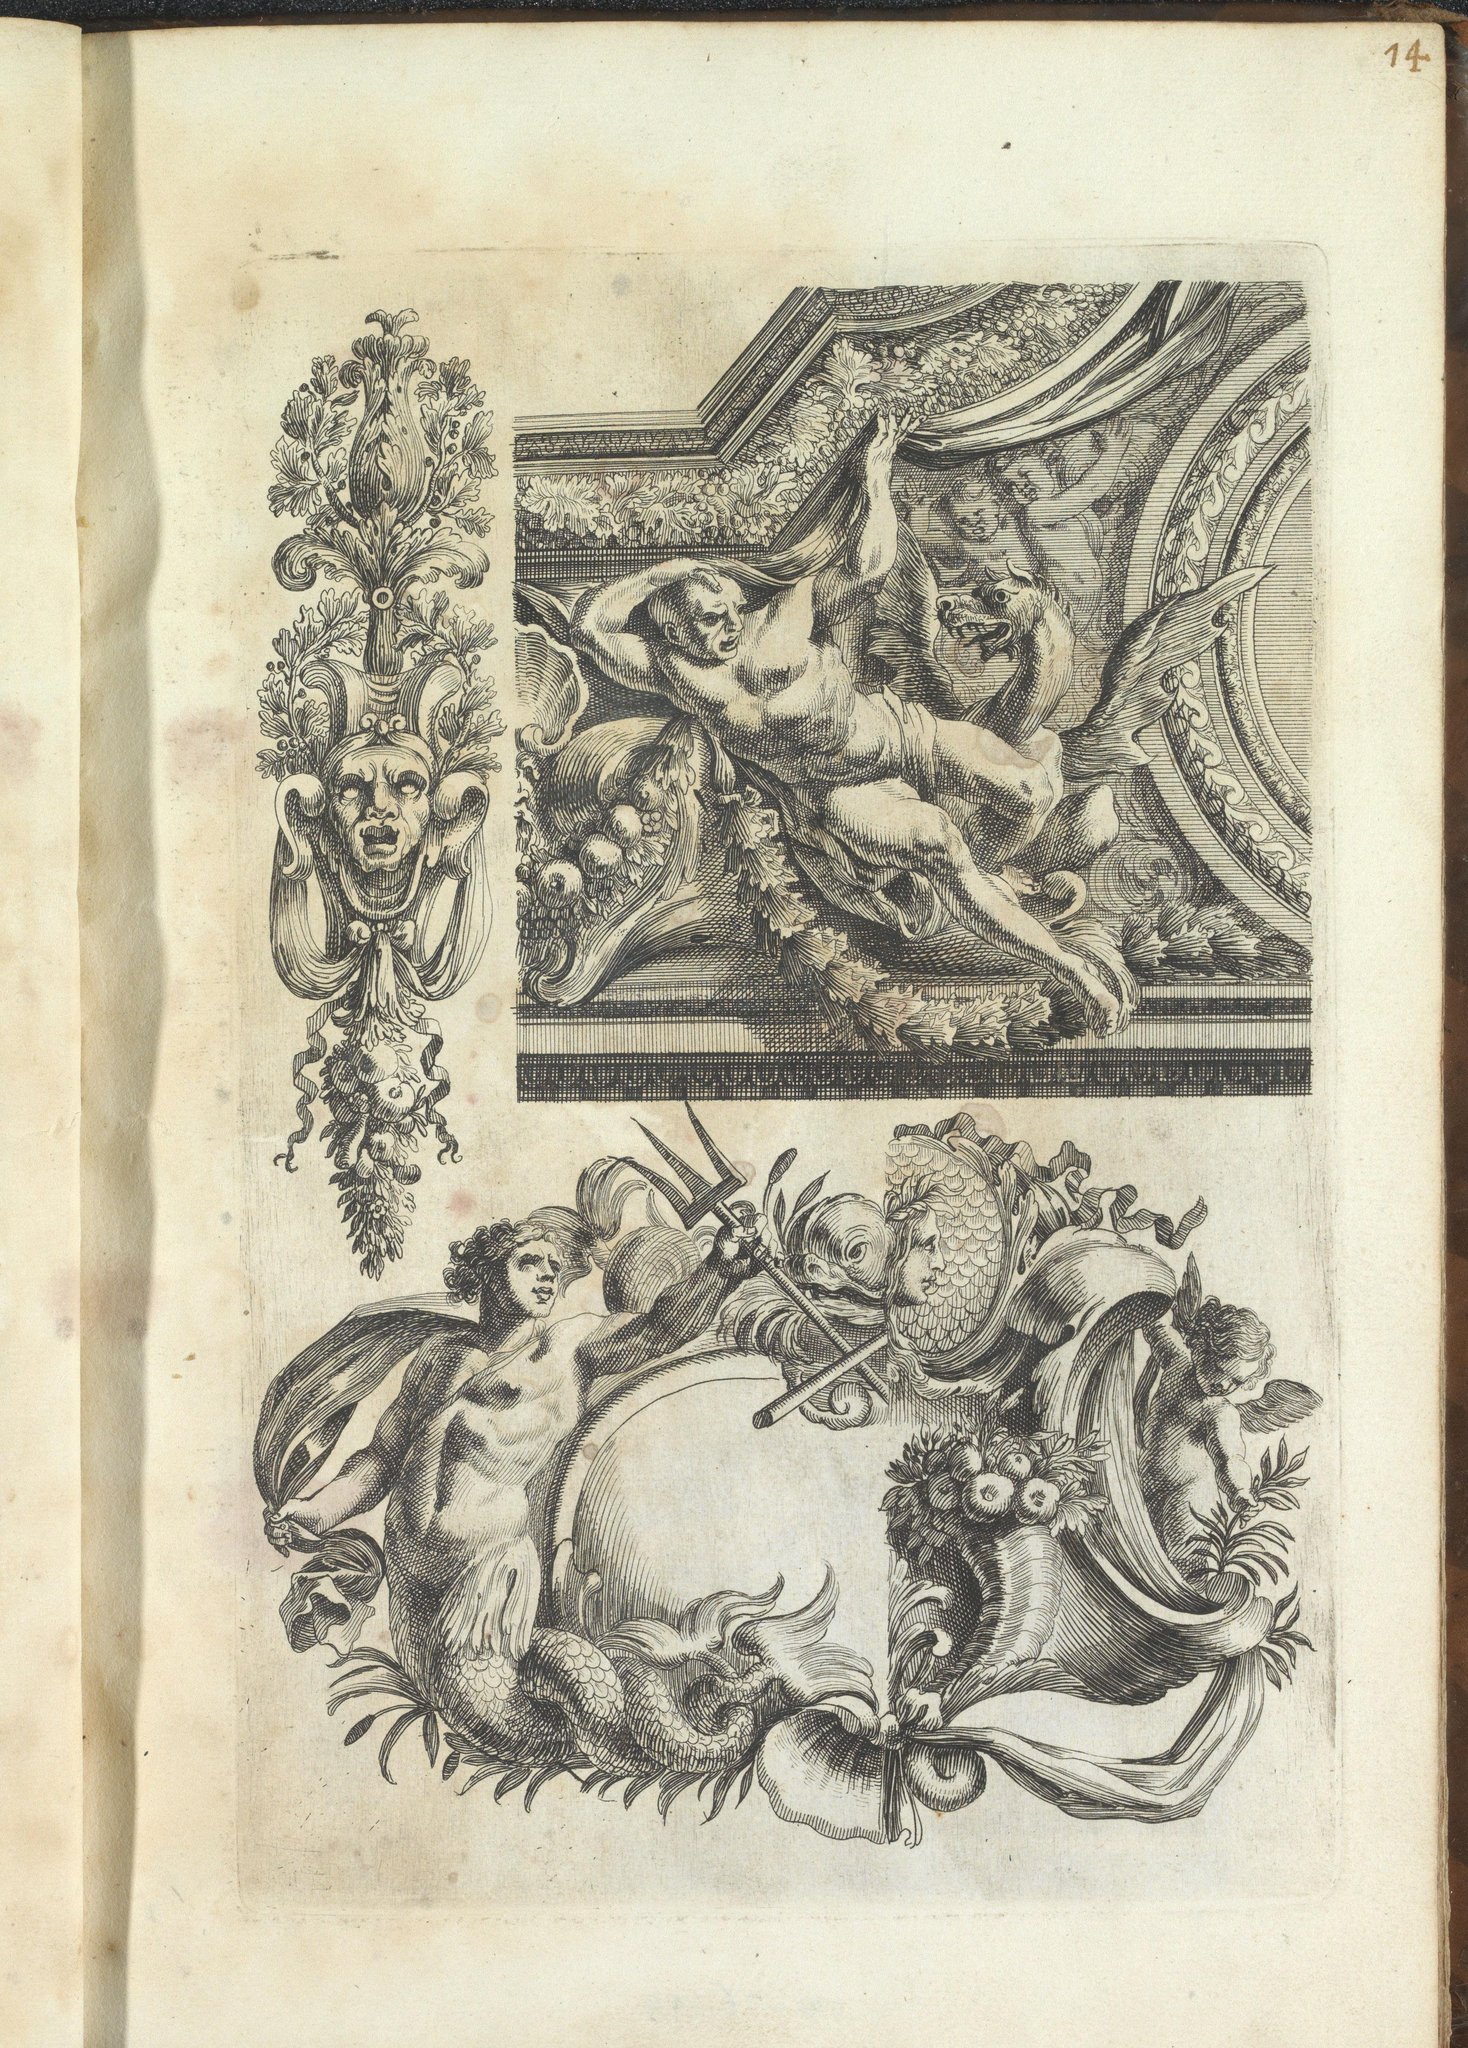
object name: print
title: Varie soffiti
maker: cornelis galle (ii)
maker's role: print maker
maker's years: 1615-1678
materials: paper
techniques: etching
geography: antwerp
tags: 'cornucopia', horn of plenty, ornaments ~ art, triton(s), (decorated) ceiling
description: Onderaan is een cartouche met een triton te zien, met een variant voor de rechterhelft. Prent maakt deel uit van een album.